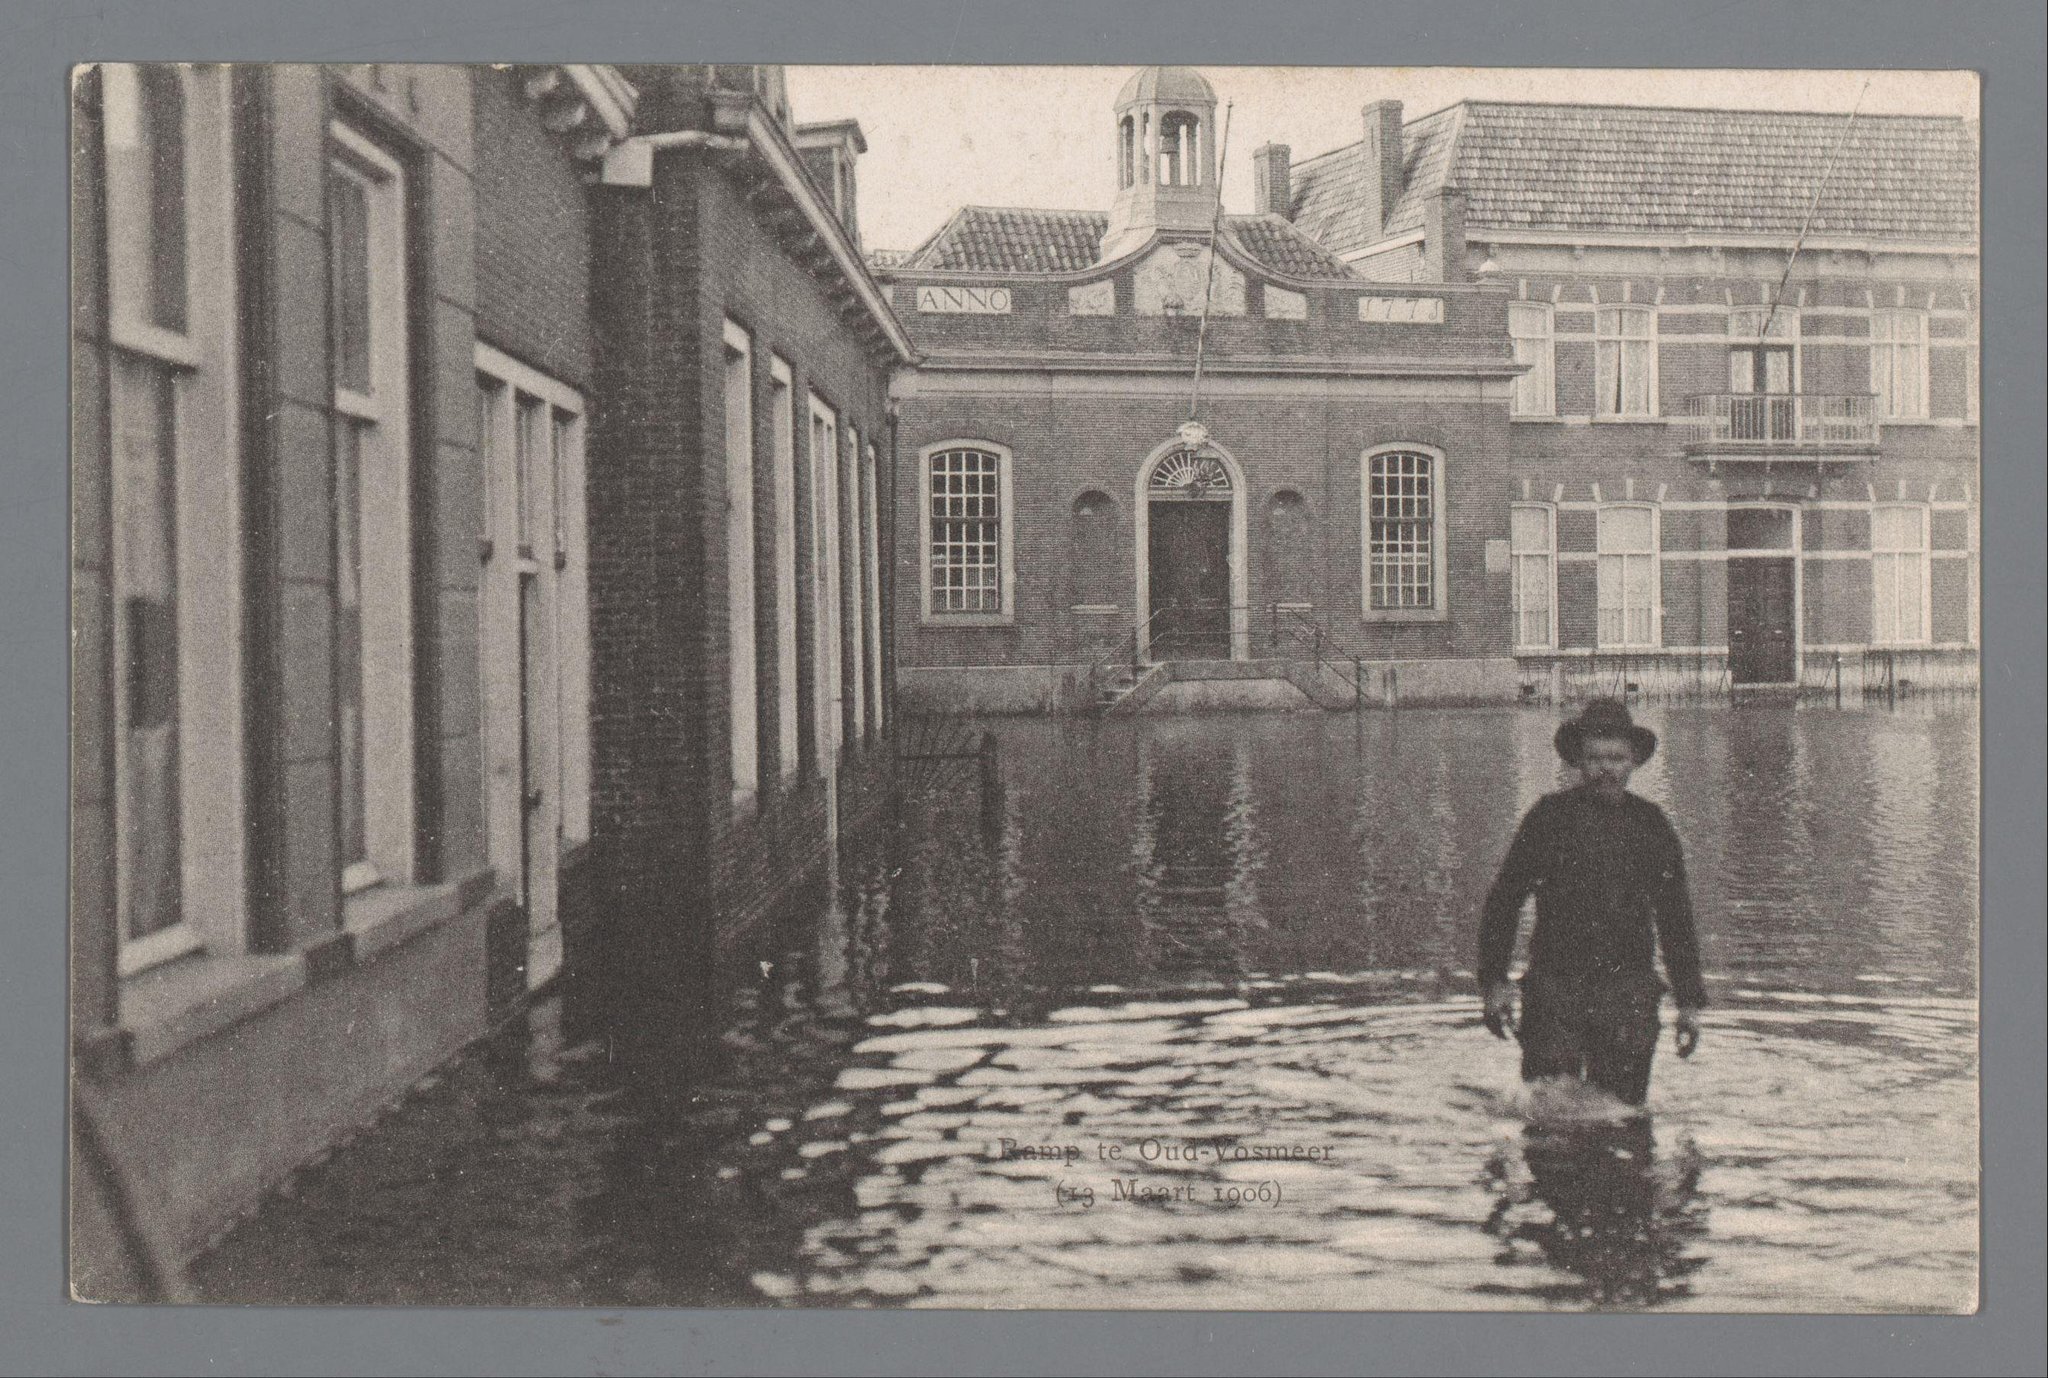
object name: ansichtkaart, prentbriefkaart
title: Ramp te Oud-Vossemeer op 13 maart 1906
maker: p.j. daniëlse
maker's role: publisher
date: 1906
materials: paper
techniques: printing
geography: middelburg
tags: zeeland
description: Briefkaart, zwart-wit. Ramp Oud-Vossemeer, 13 maart 1906.